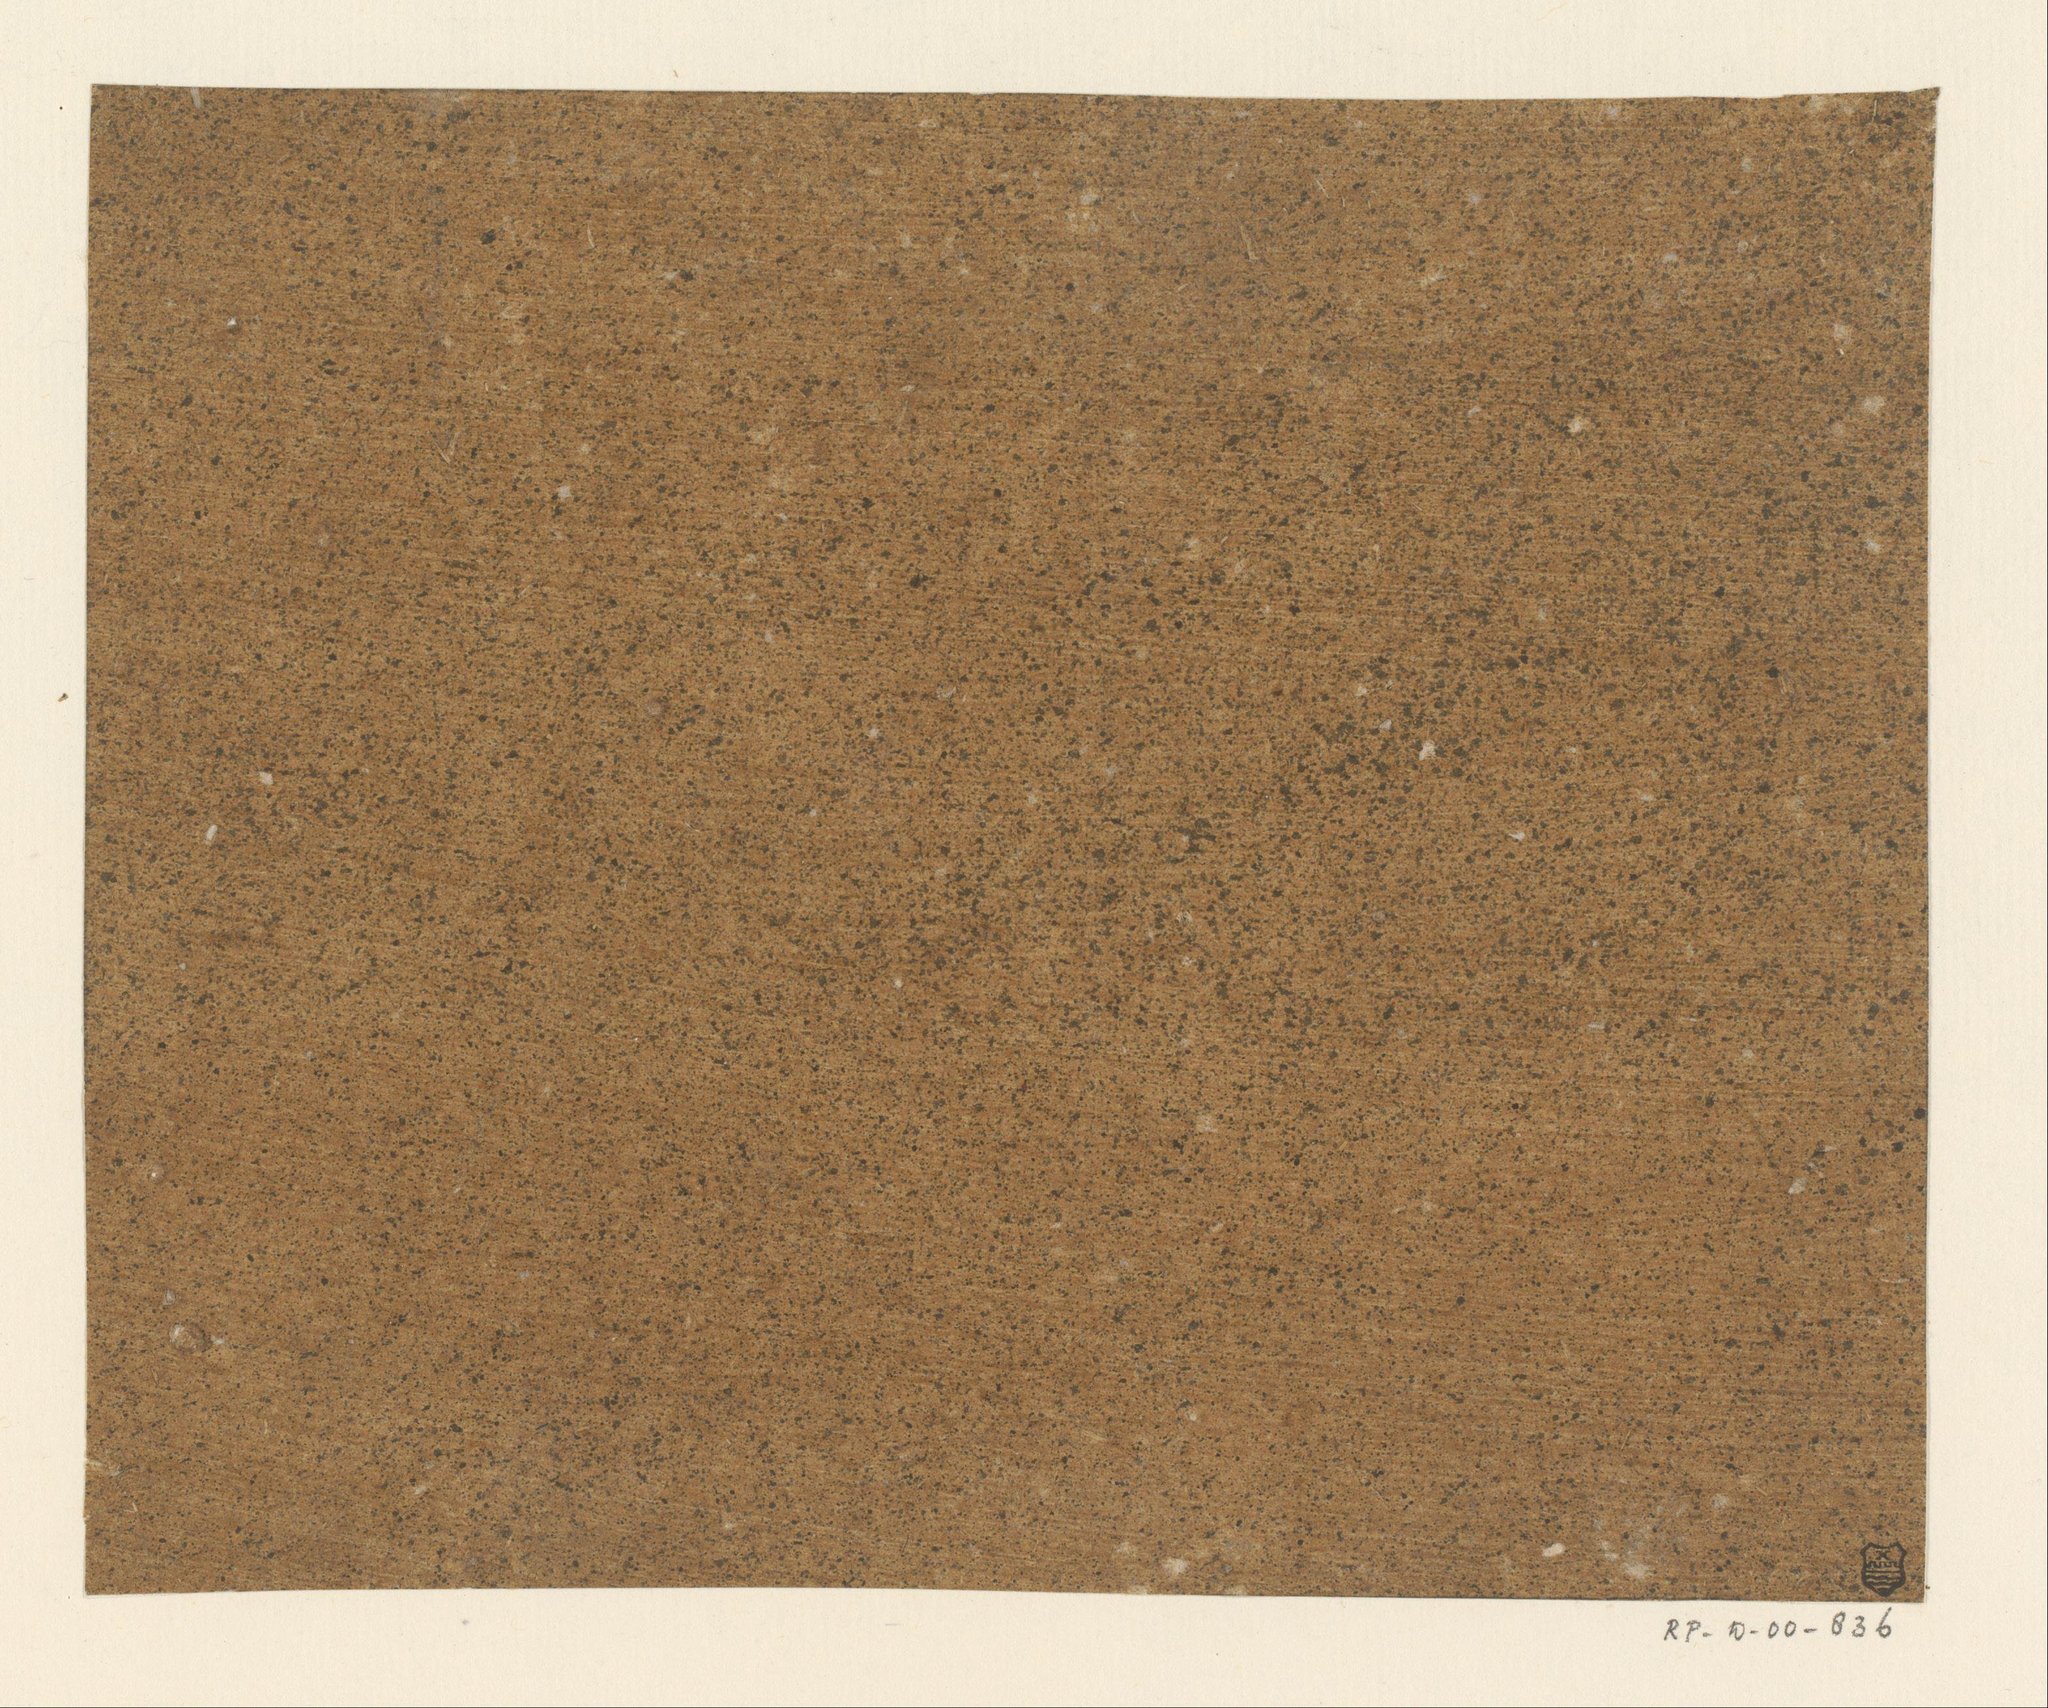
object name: sprinkled paper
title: Zwart gespikkeld bruin papier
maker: Anonymous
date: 1750-1900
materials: paper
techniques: kievitsmarmer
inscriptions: collector's mark: Lugt 2760